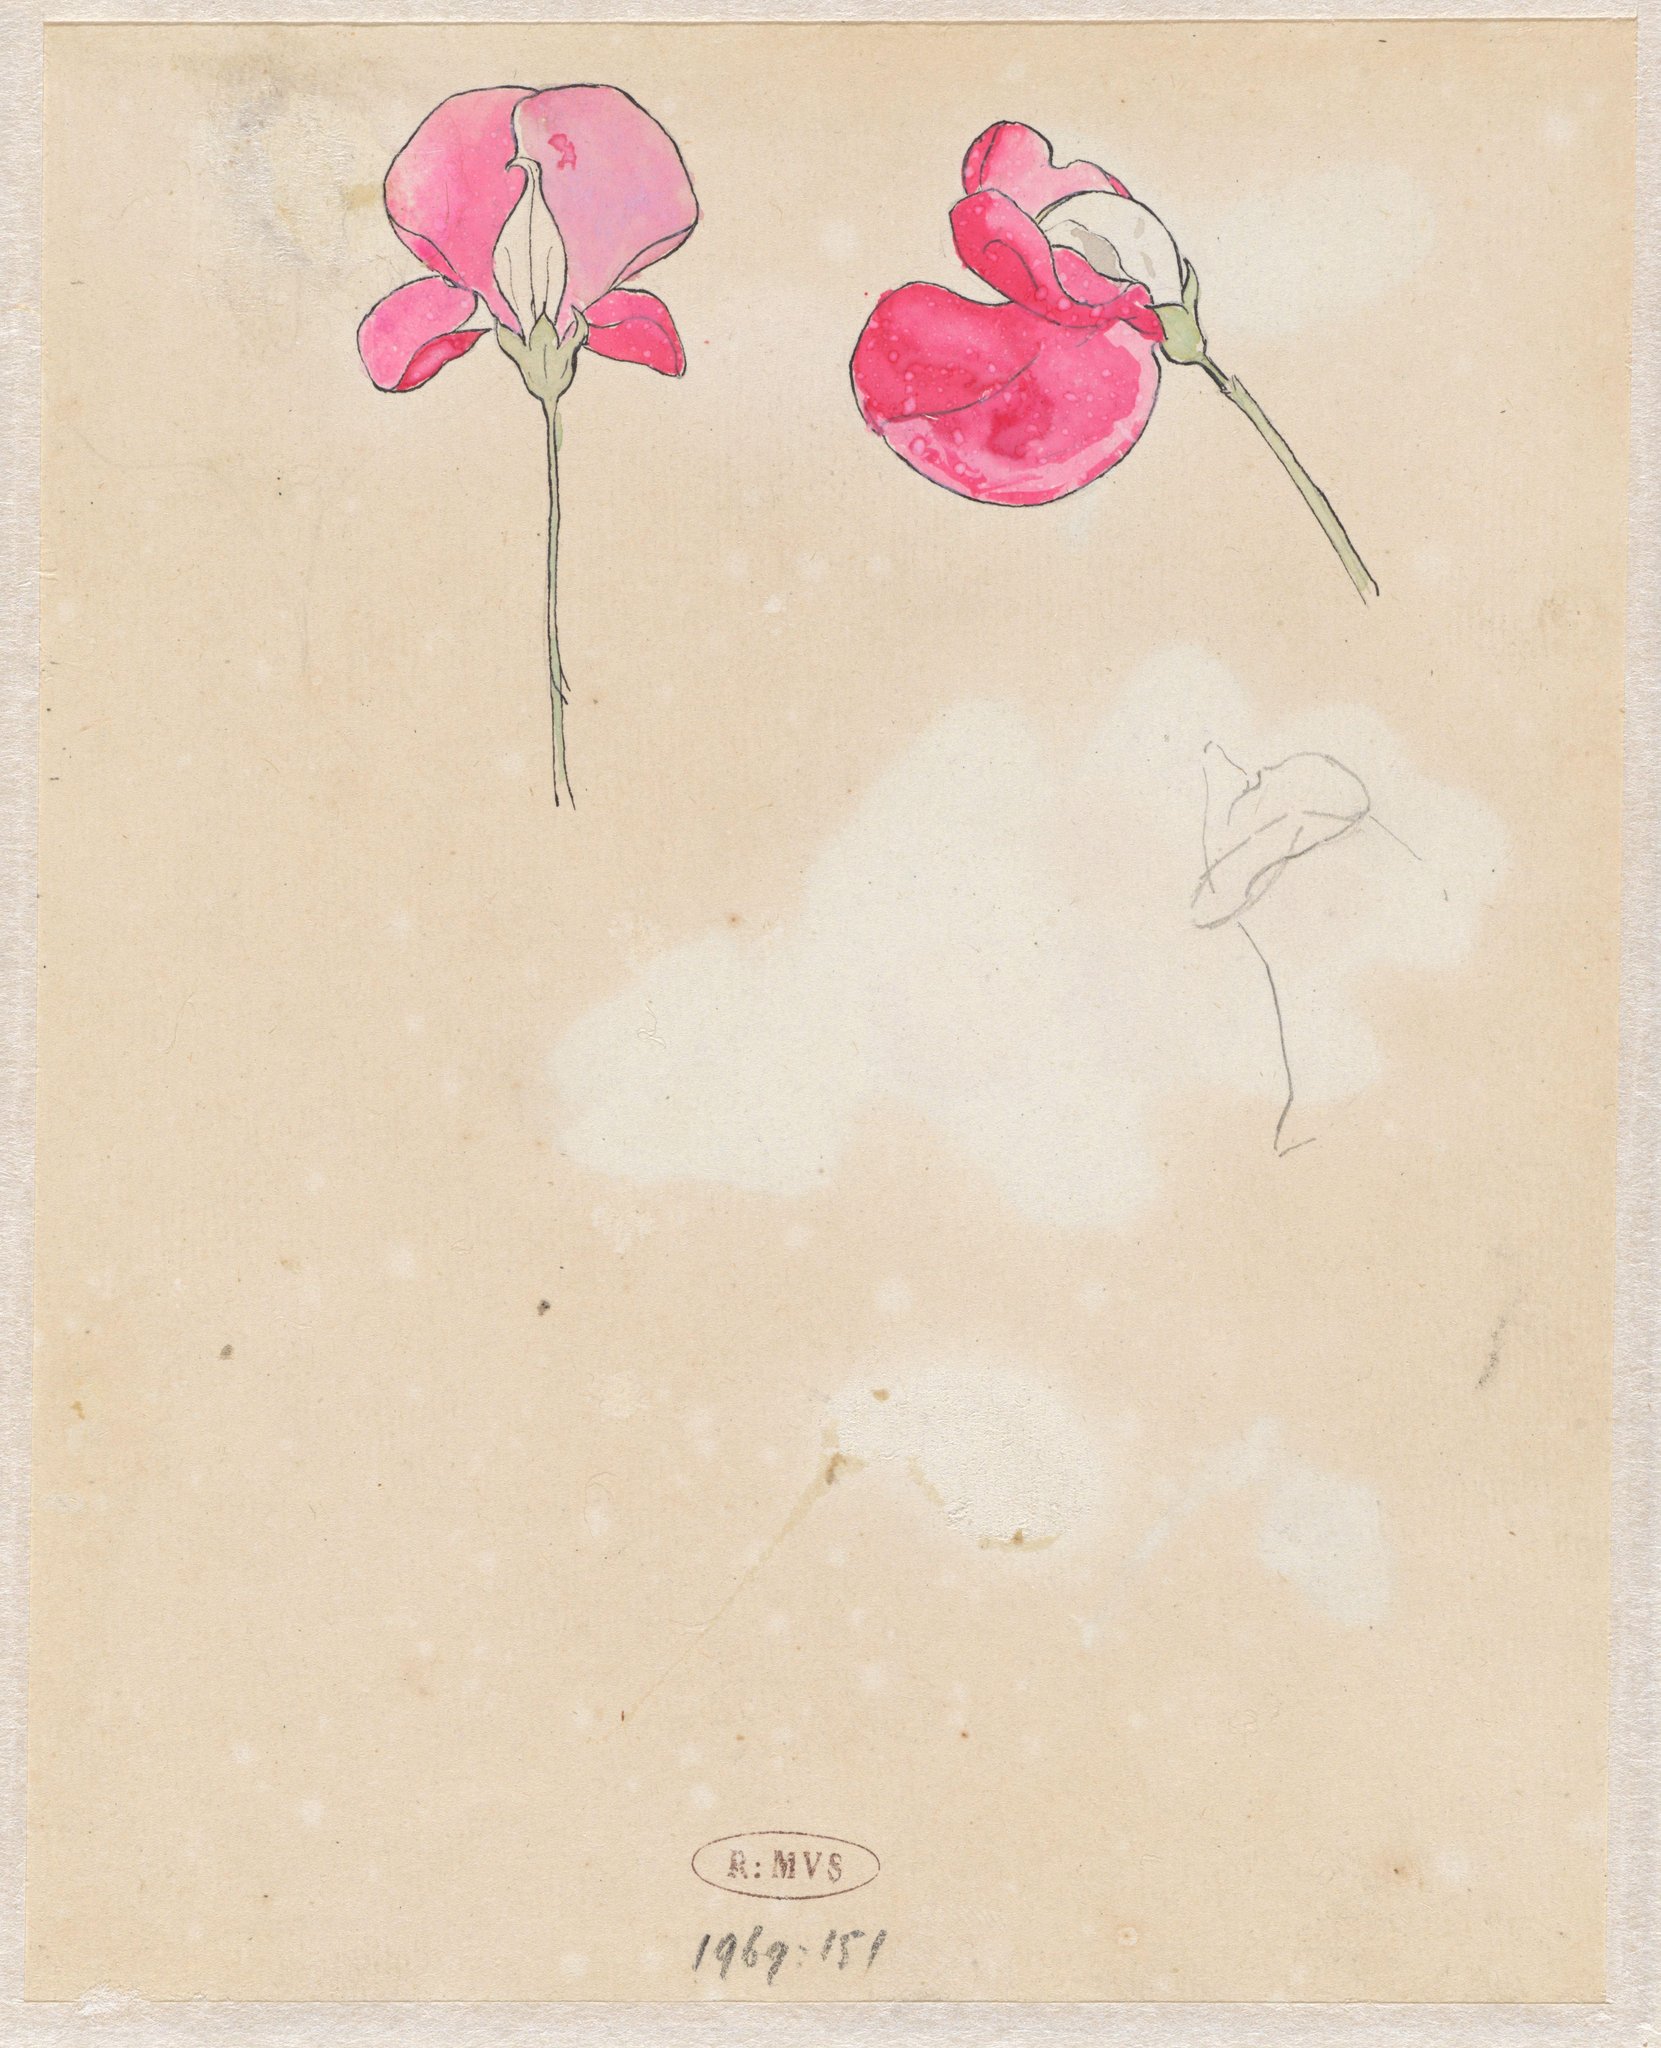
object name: drawing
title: Lathyrus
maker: theo nieuwenhuis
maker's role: designer, draughtsman, print maker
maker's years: 1866-1951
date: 1876-1951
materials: ink, paper, watercolor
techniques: brush, pen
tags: flowers: lathyrus